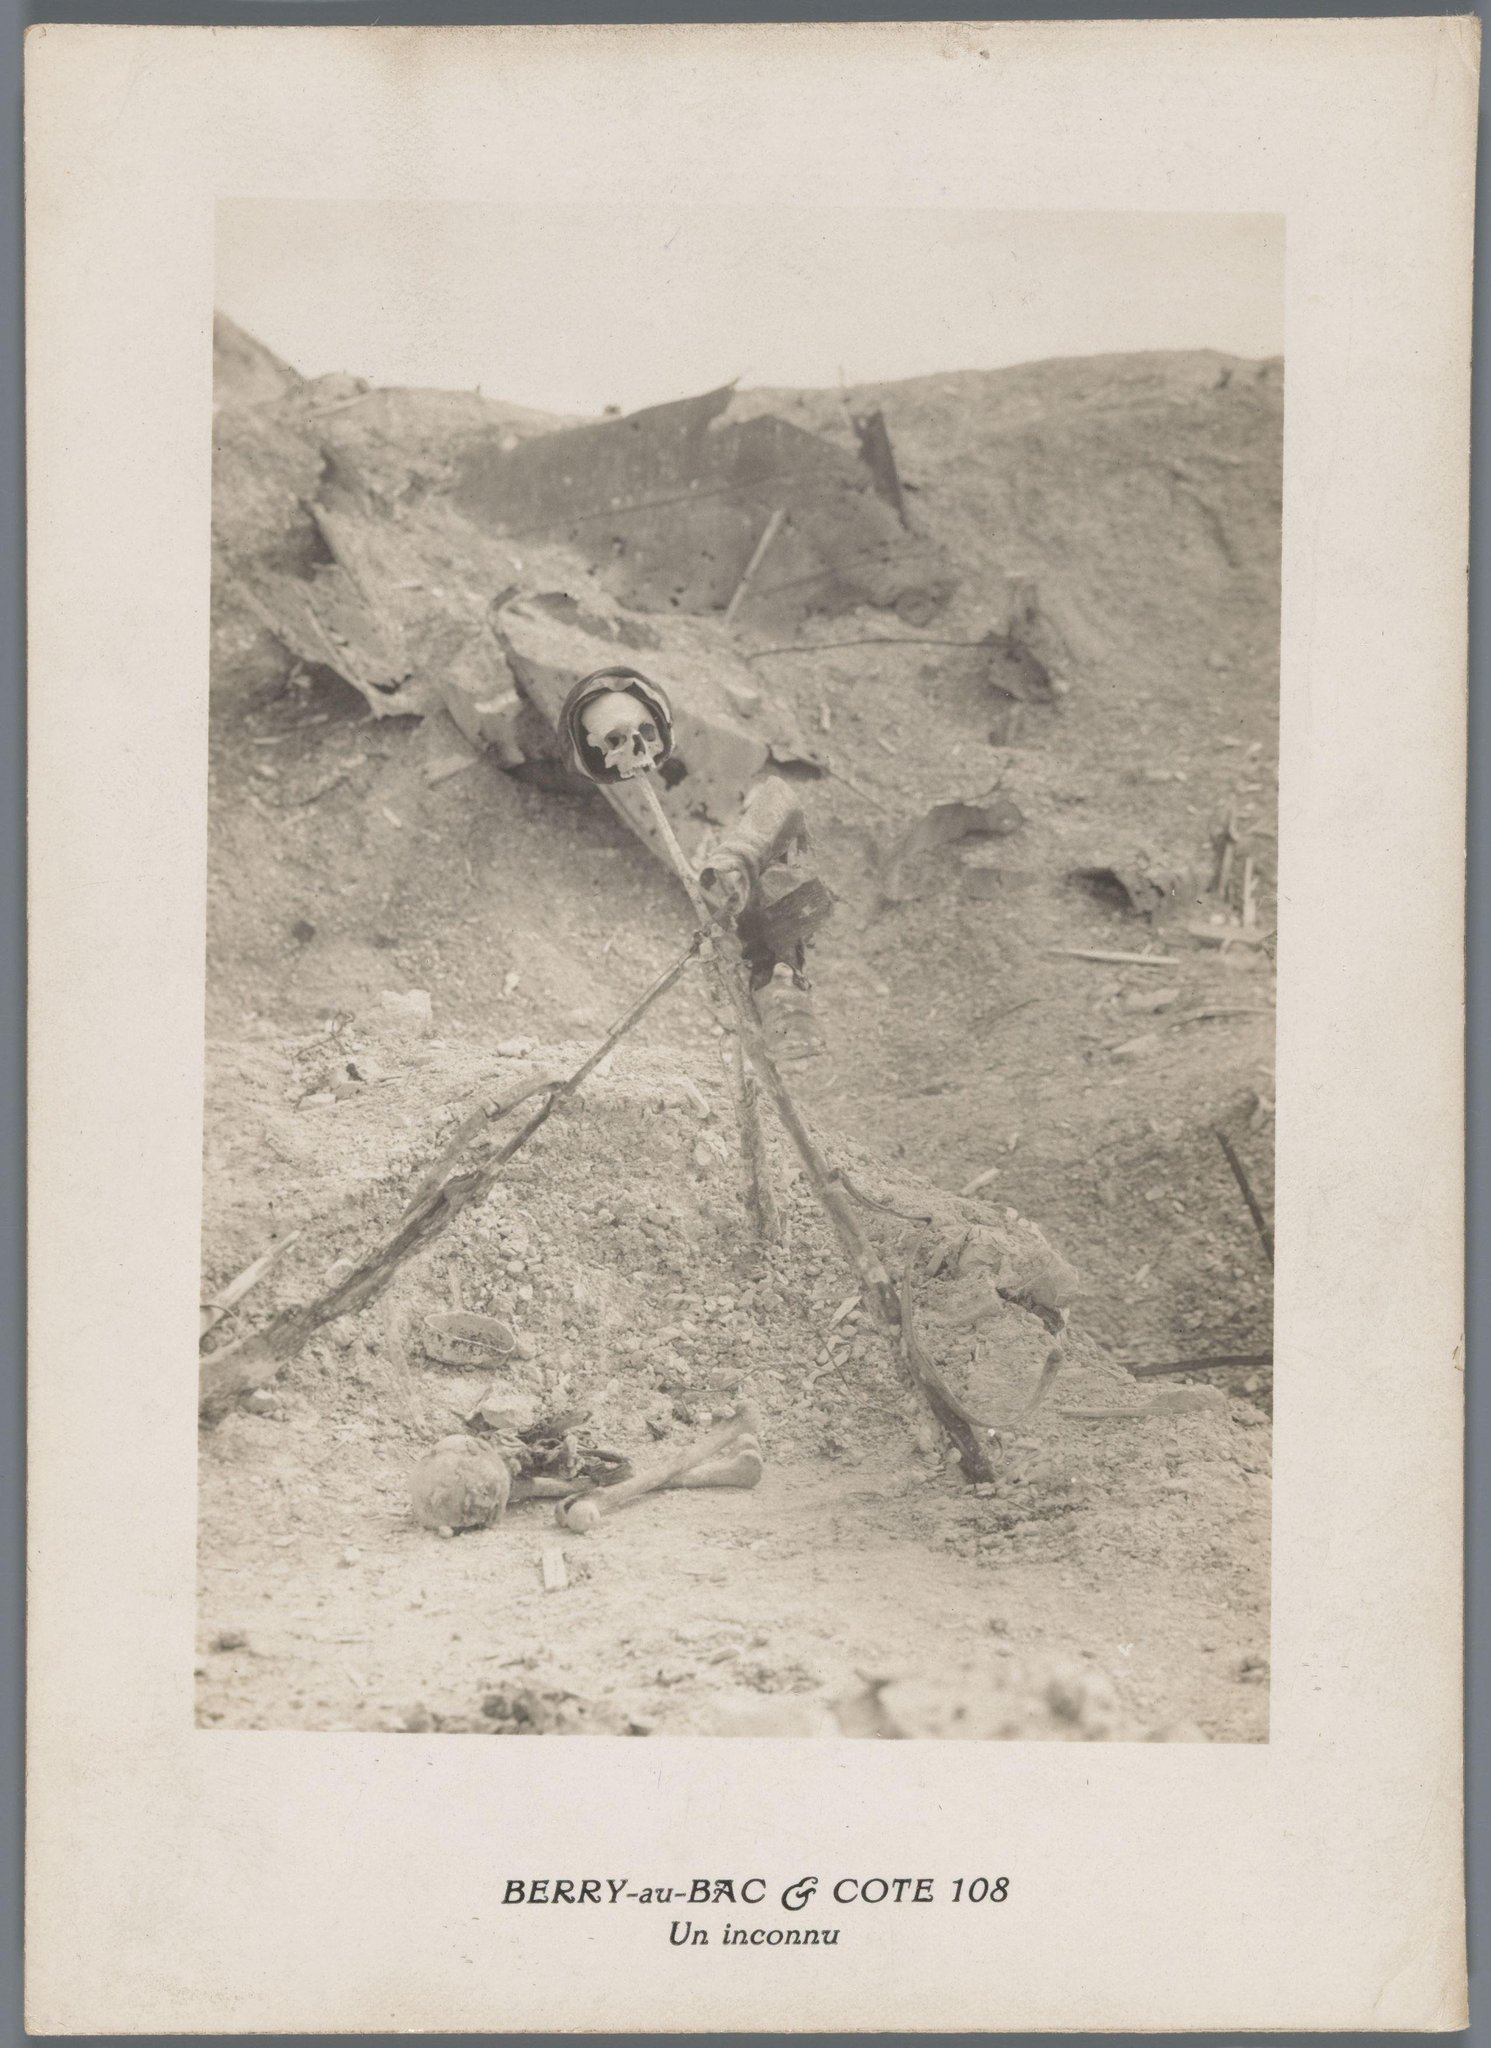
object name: photograph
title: Un inconnu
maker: Anonymous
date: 1914-1918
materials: paper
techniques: gelatin silver print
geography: berry-au-bac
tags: devastated, ruined place or city (~ warfare), death's head, skull (symbol of death)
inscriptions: inscription: ‘Berry-au-Bac & Cote 108’